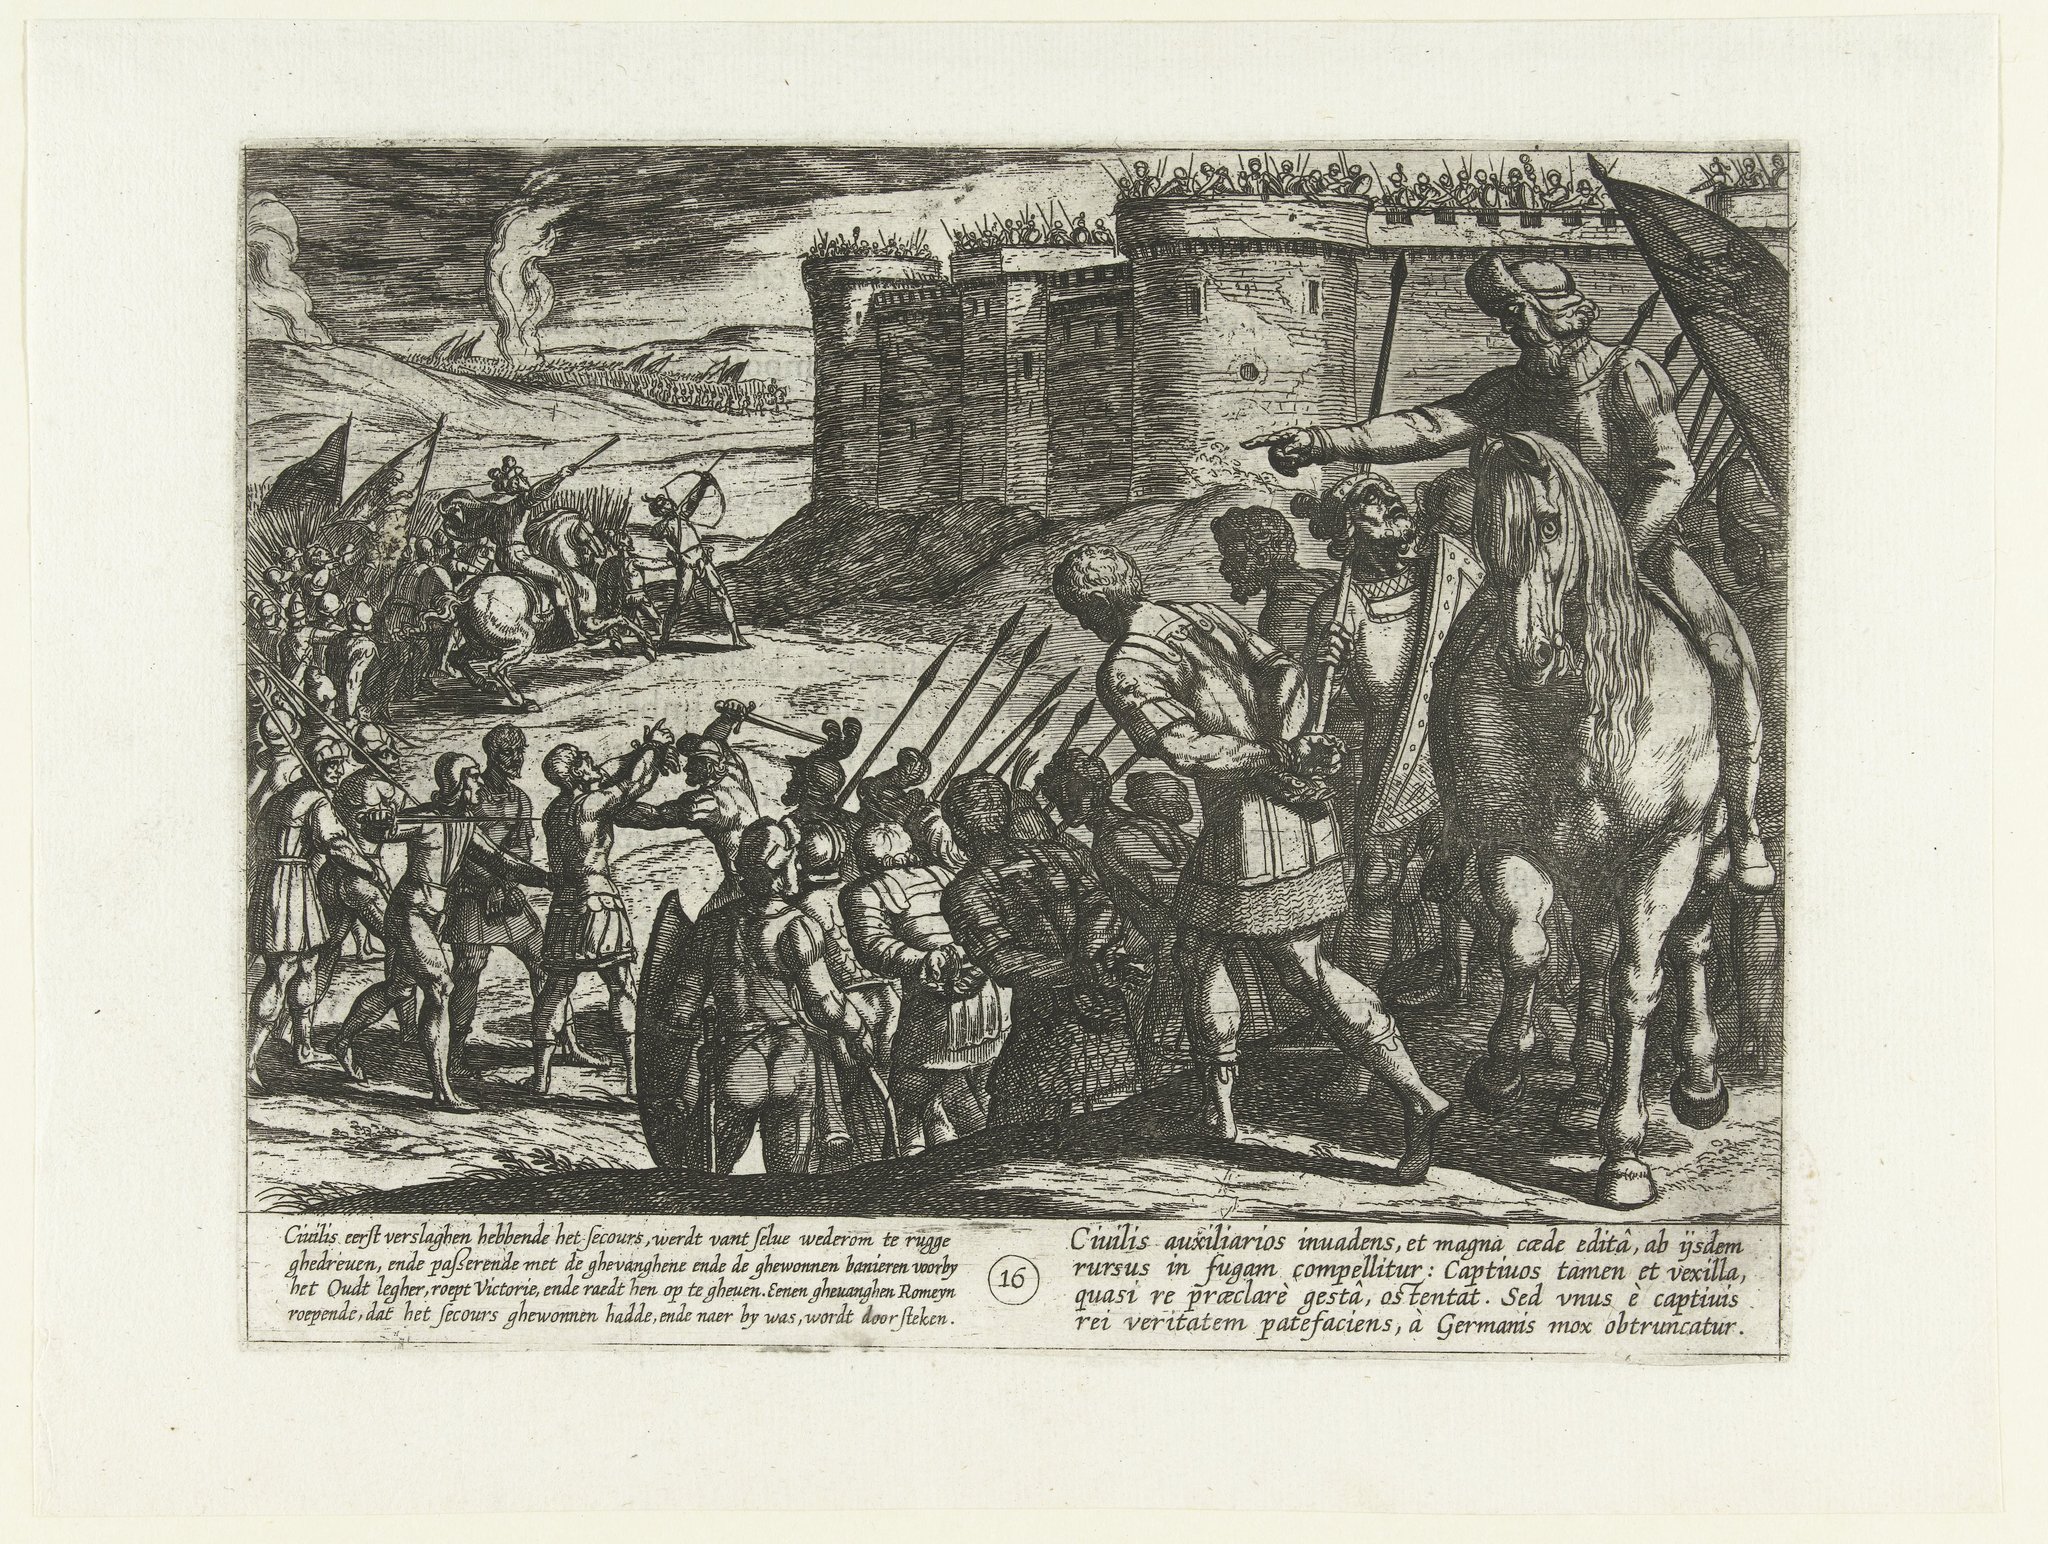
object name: print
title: Romeinse gevangen langs de vesting geleid, 69-70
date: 1612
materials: paper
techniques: etching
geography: italy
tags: battle, fighting in general, extinct, 'historical' peoples (with name), netherlands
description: Gevangengenomen Romeinse soldaten en vaandels worden langs de Romeinse vesting geleid. Prent nummer 16 in de serie prenten over de Bataafse Opstand: Batavorum cum Romanis bellum / à Corn. Tacito lib. IV & V. : Hist. olim descriptum, figuris nunc aeneis expressum, auctore Othone Vaenio Lugdunobatava = De Batavische oft oude Hollandtsche oorloghe teghen de Romeynen. Otto Vaenius, Antwerpen 1612. Onderaan twee verzen van vier regels in het Nederlands en in het Latijn. Op de achterzijde tekst in het Latijn.